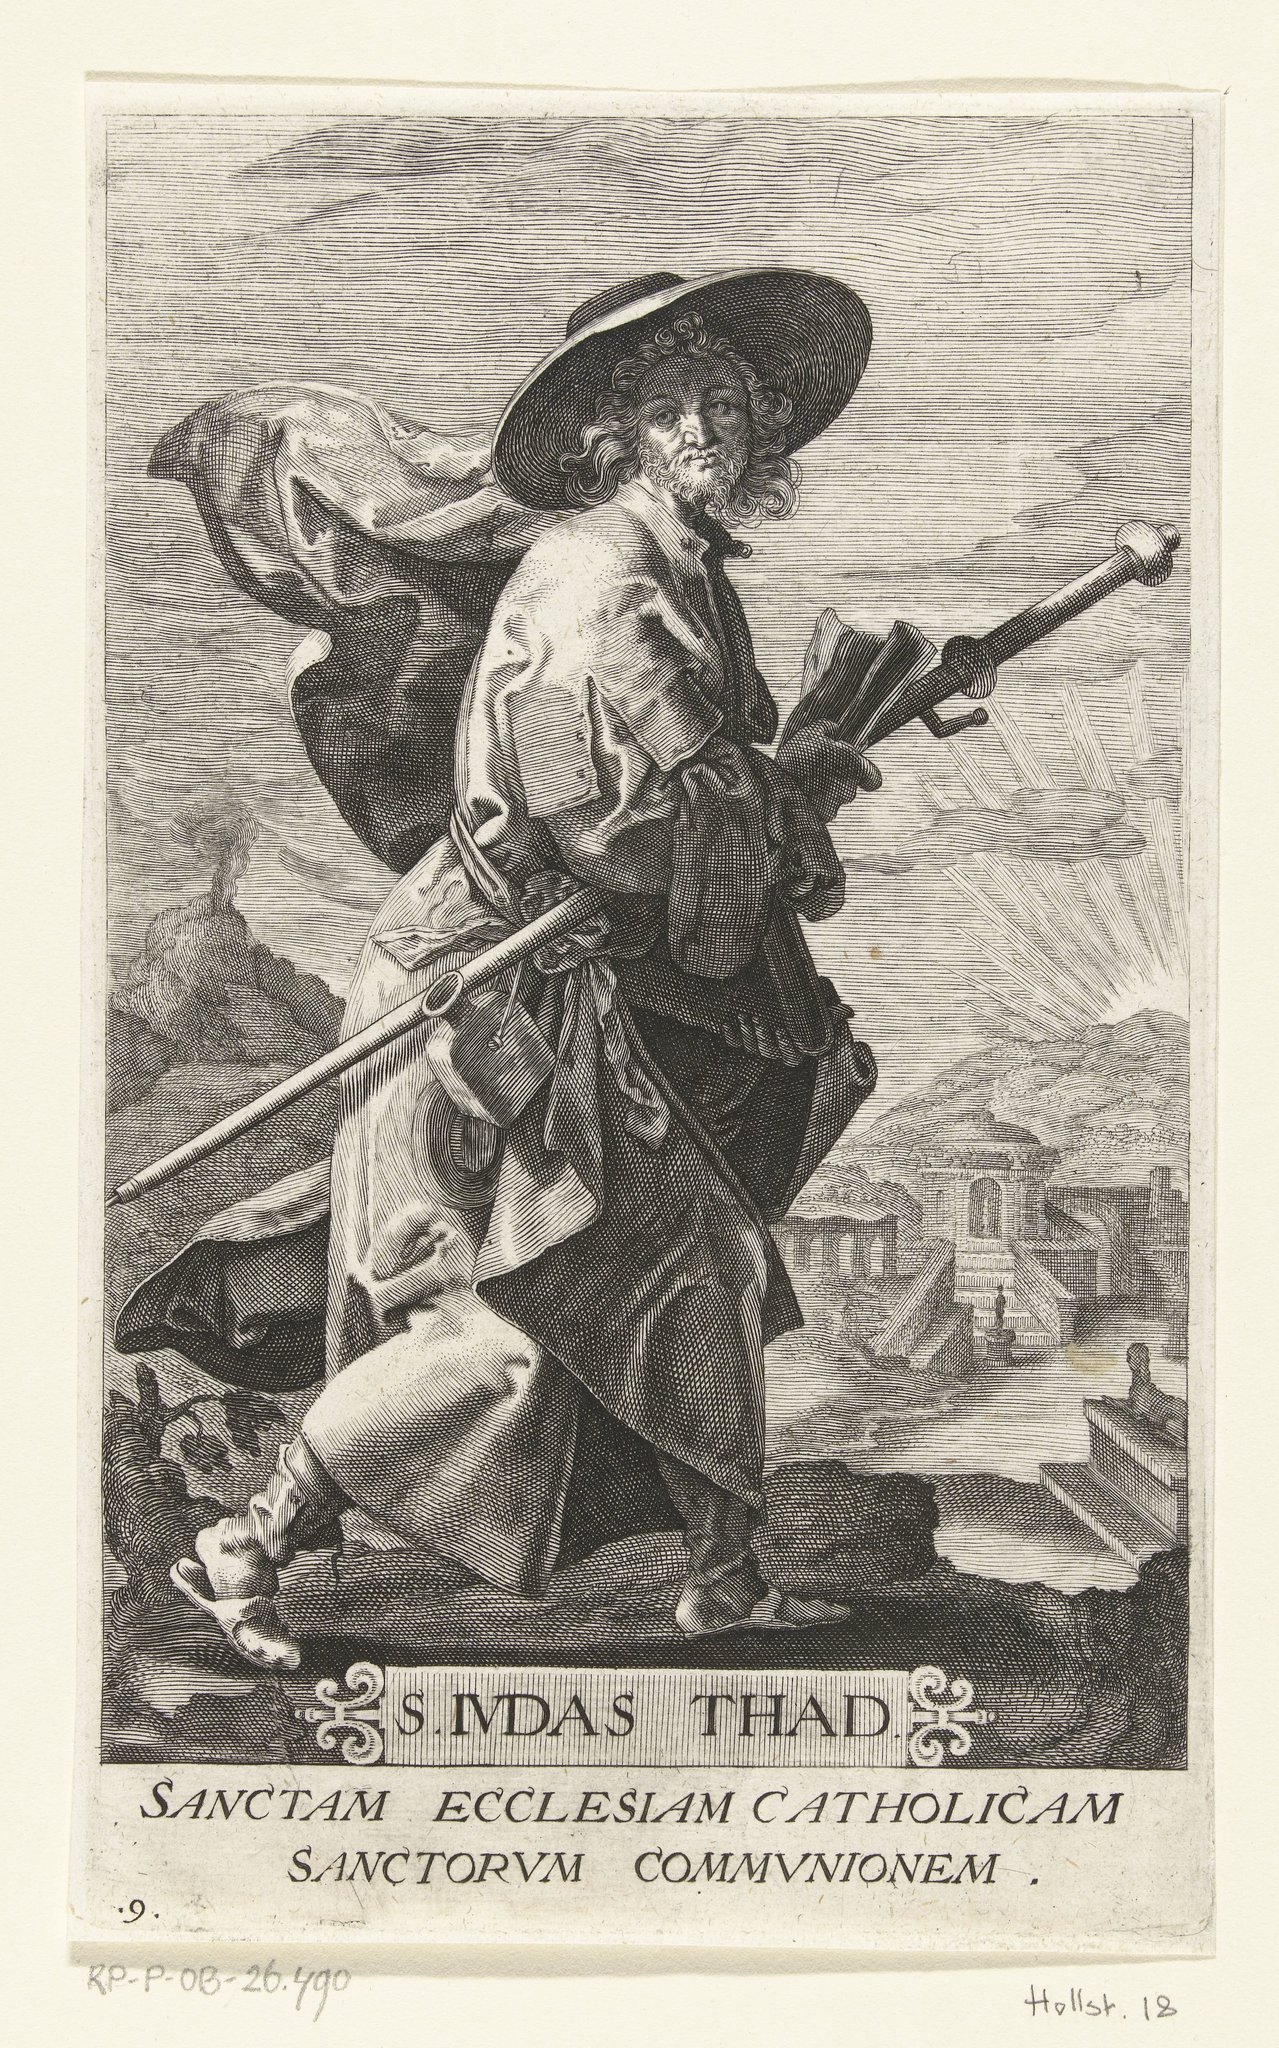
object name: print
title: Apostel Judas Taddeüs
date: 1591-1629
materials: paper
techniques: engraving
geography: prague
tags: male saints (with name)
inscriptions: collector's mark: Lugt 2228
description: Apostel Judas Taddeüs met pelgrimsstaf op zendingsreis. Onder de voorstelling staat een Latijnse regel uit de apostolische geloofsbelijdenis.